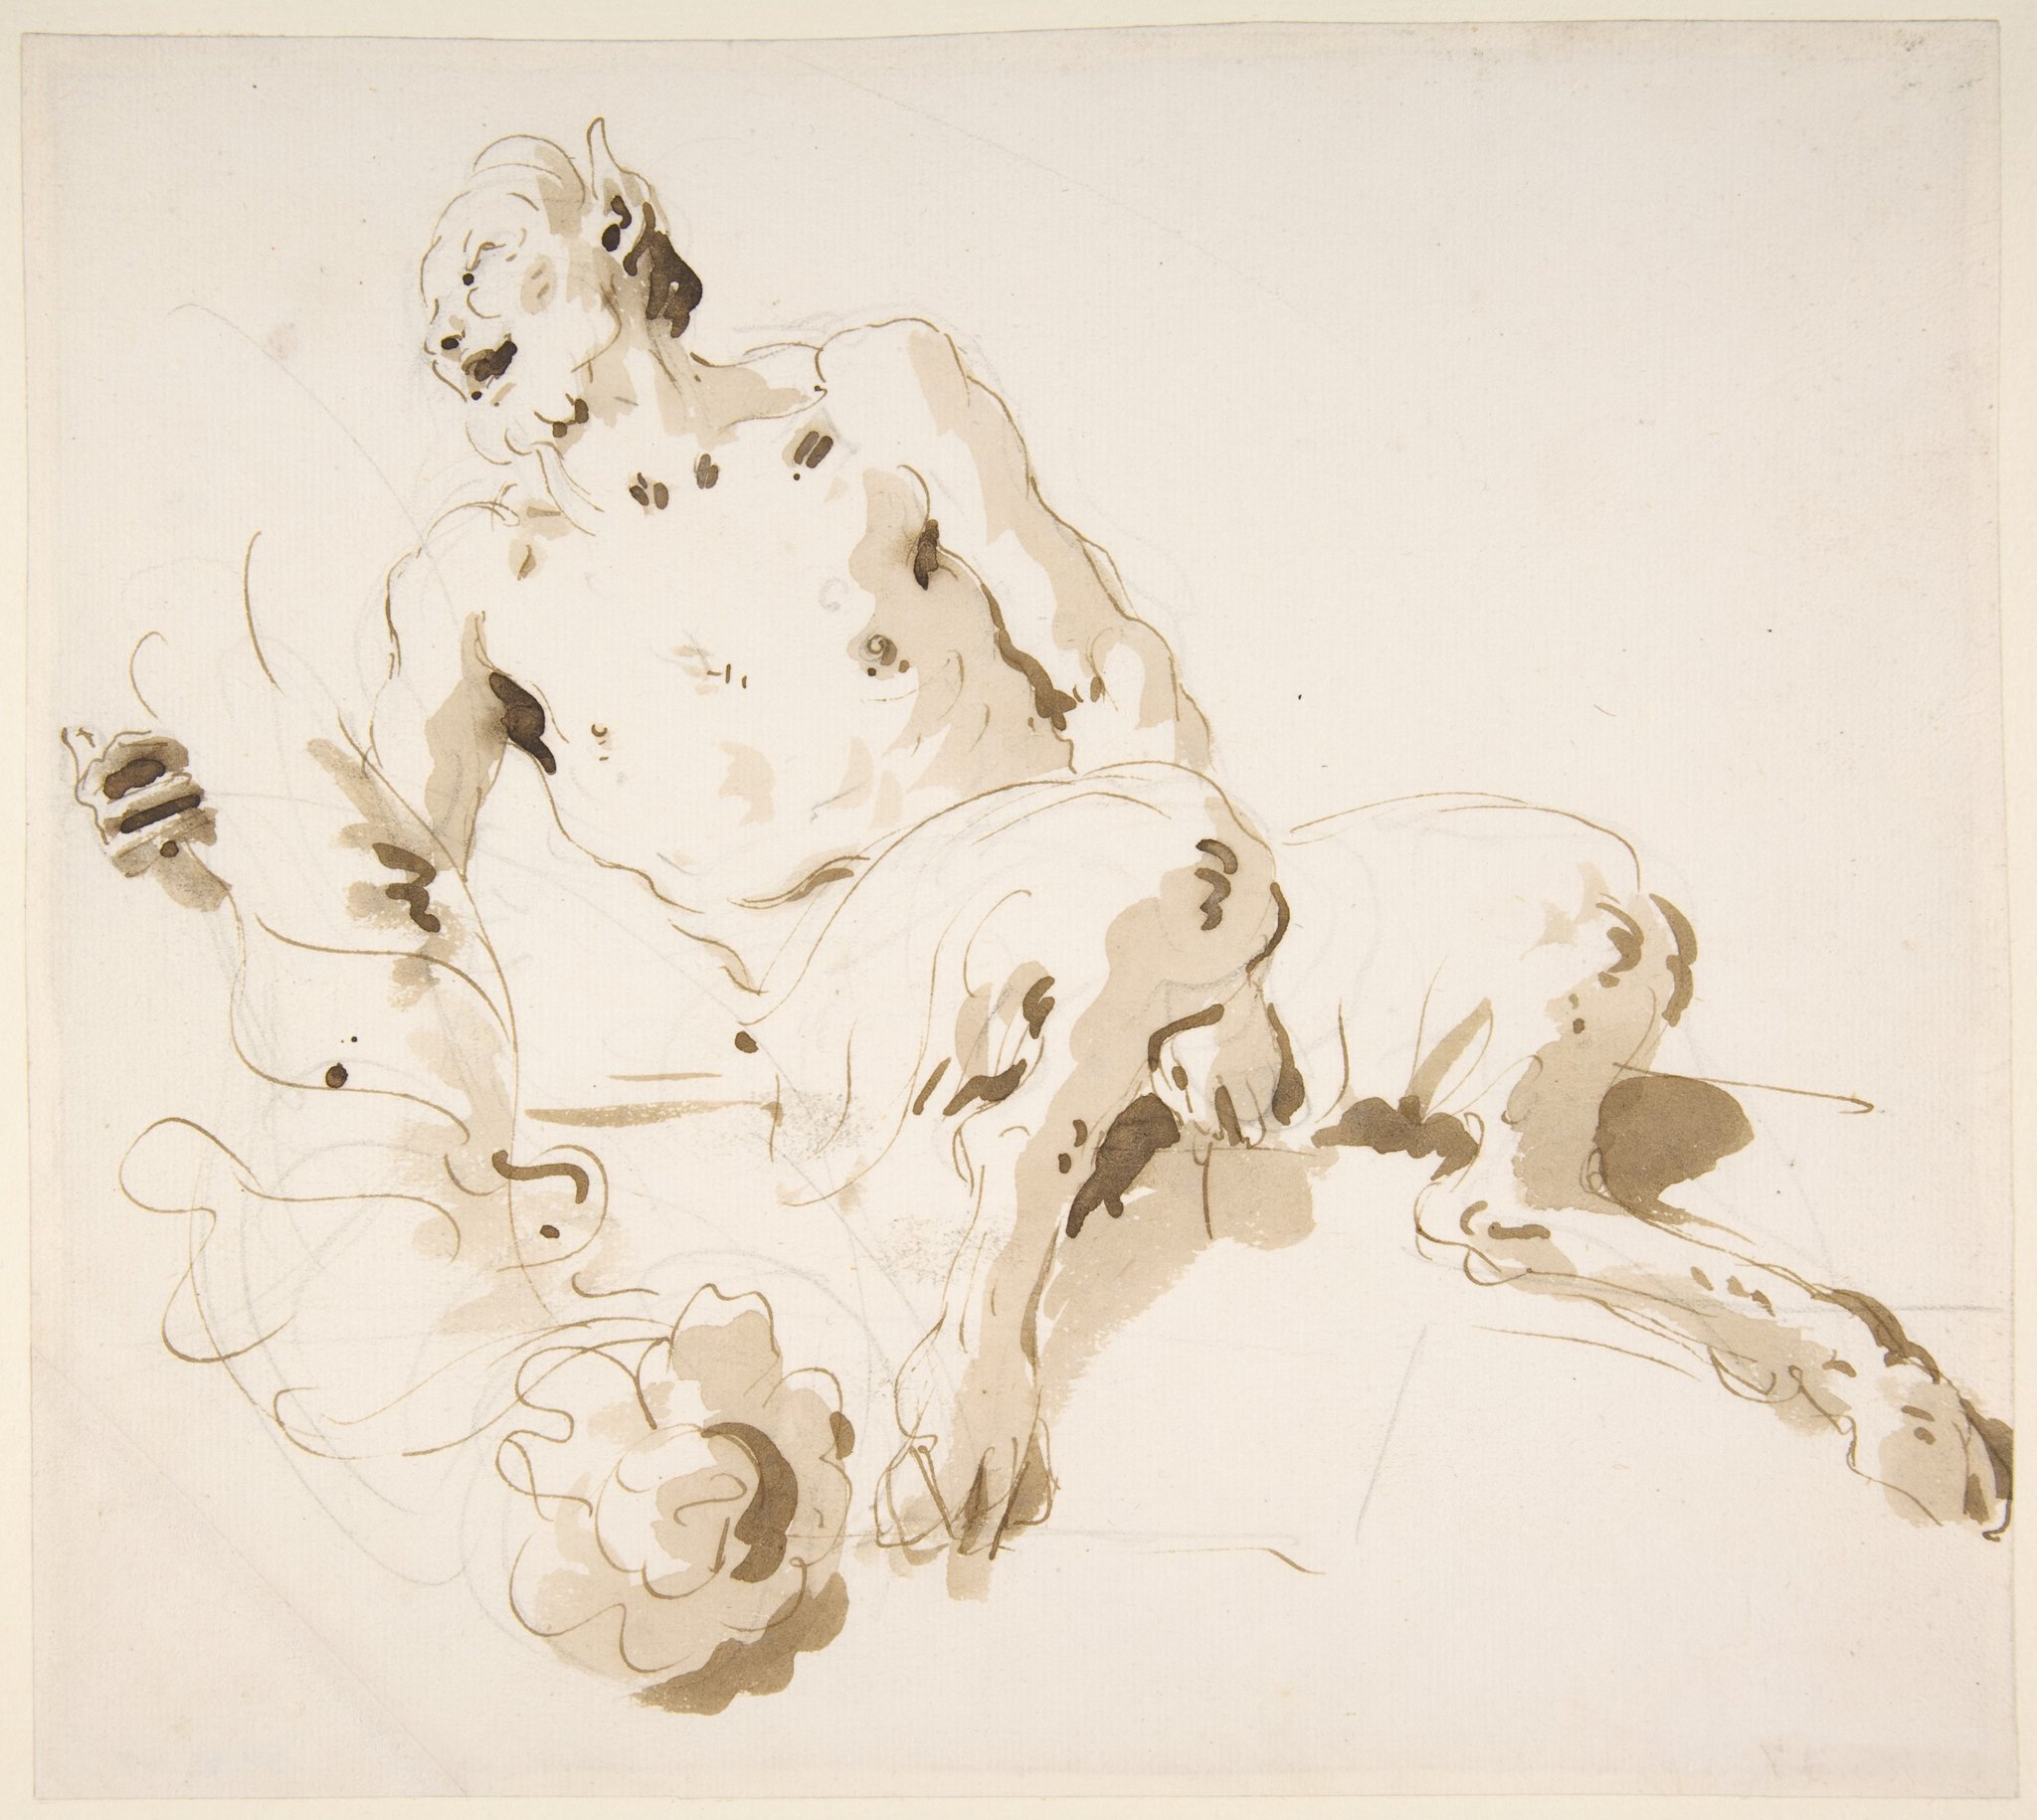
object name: drawing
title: Seated Satyr Holding a Garland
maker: giovanni battista tiepolo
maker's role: artist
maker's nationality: italian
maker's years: 1696-1770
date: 1696-1770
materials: chalk, ink, drawing material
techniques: brush, pen, wash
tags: satyrs